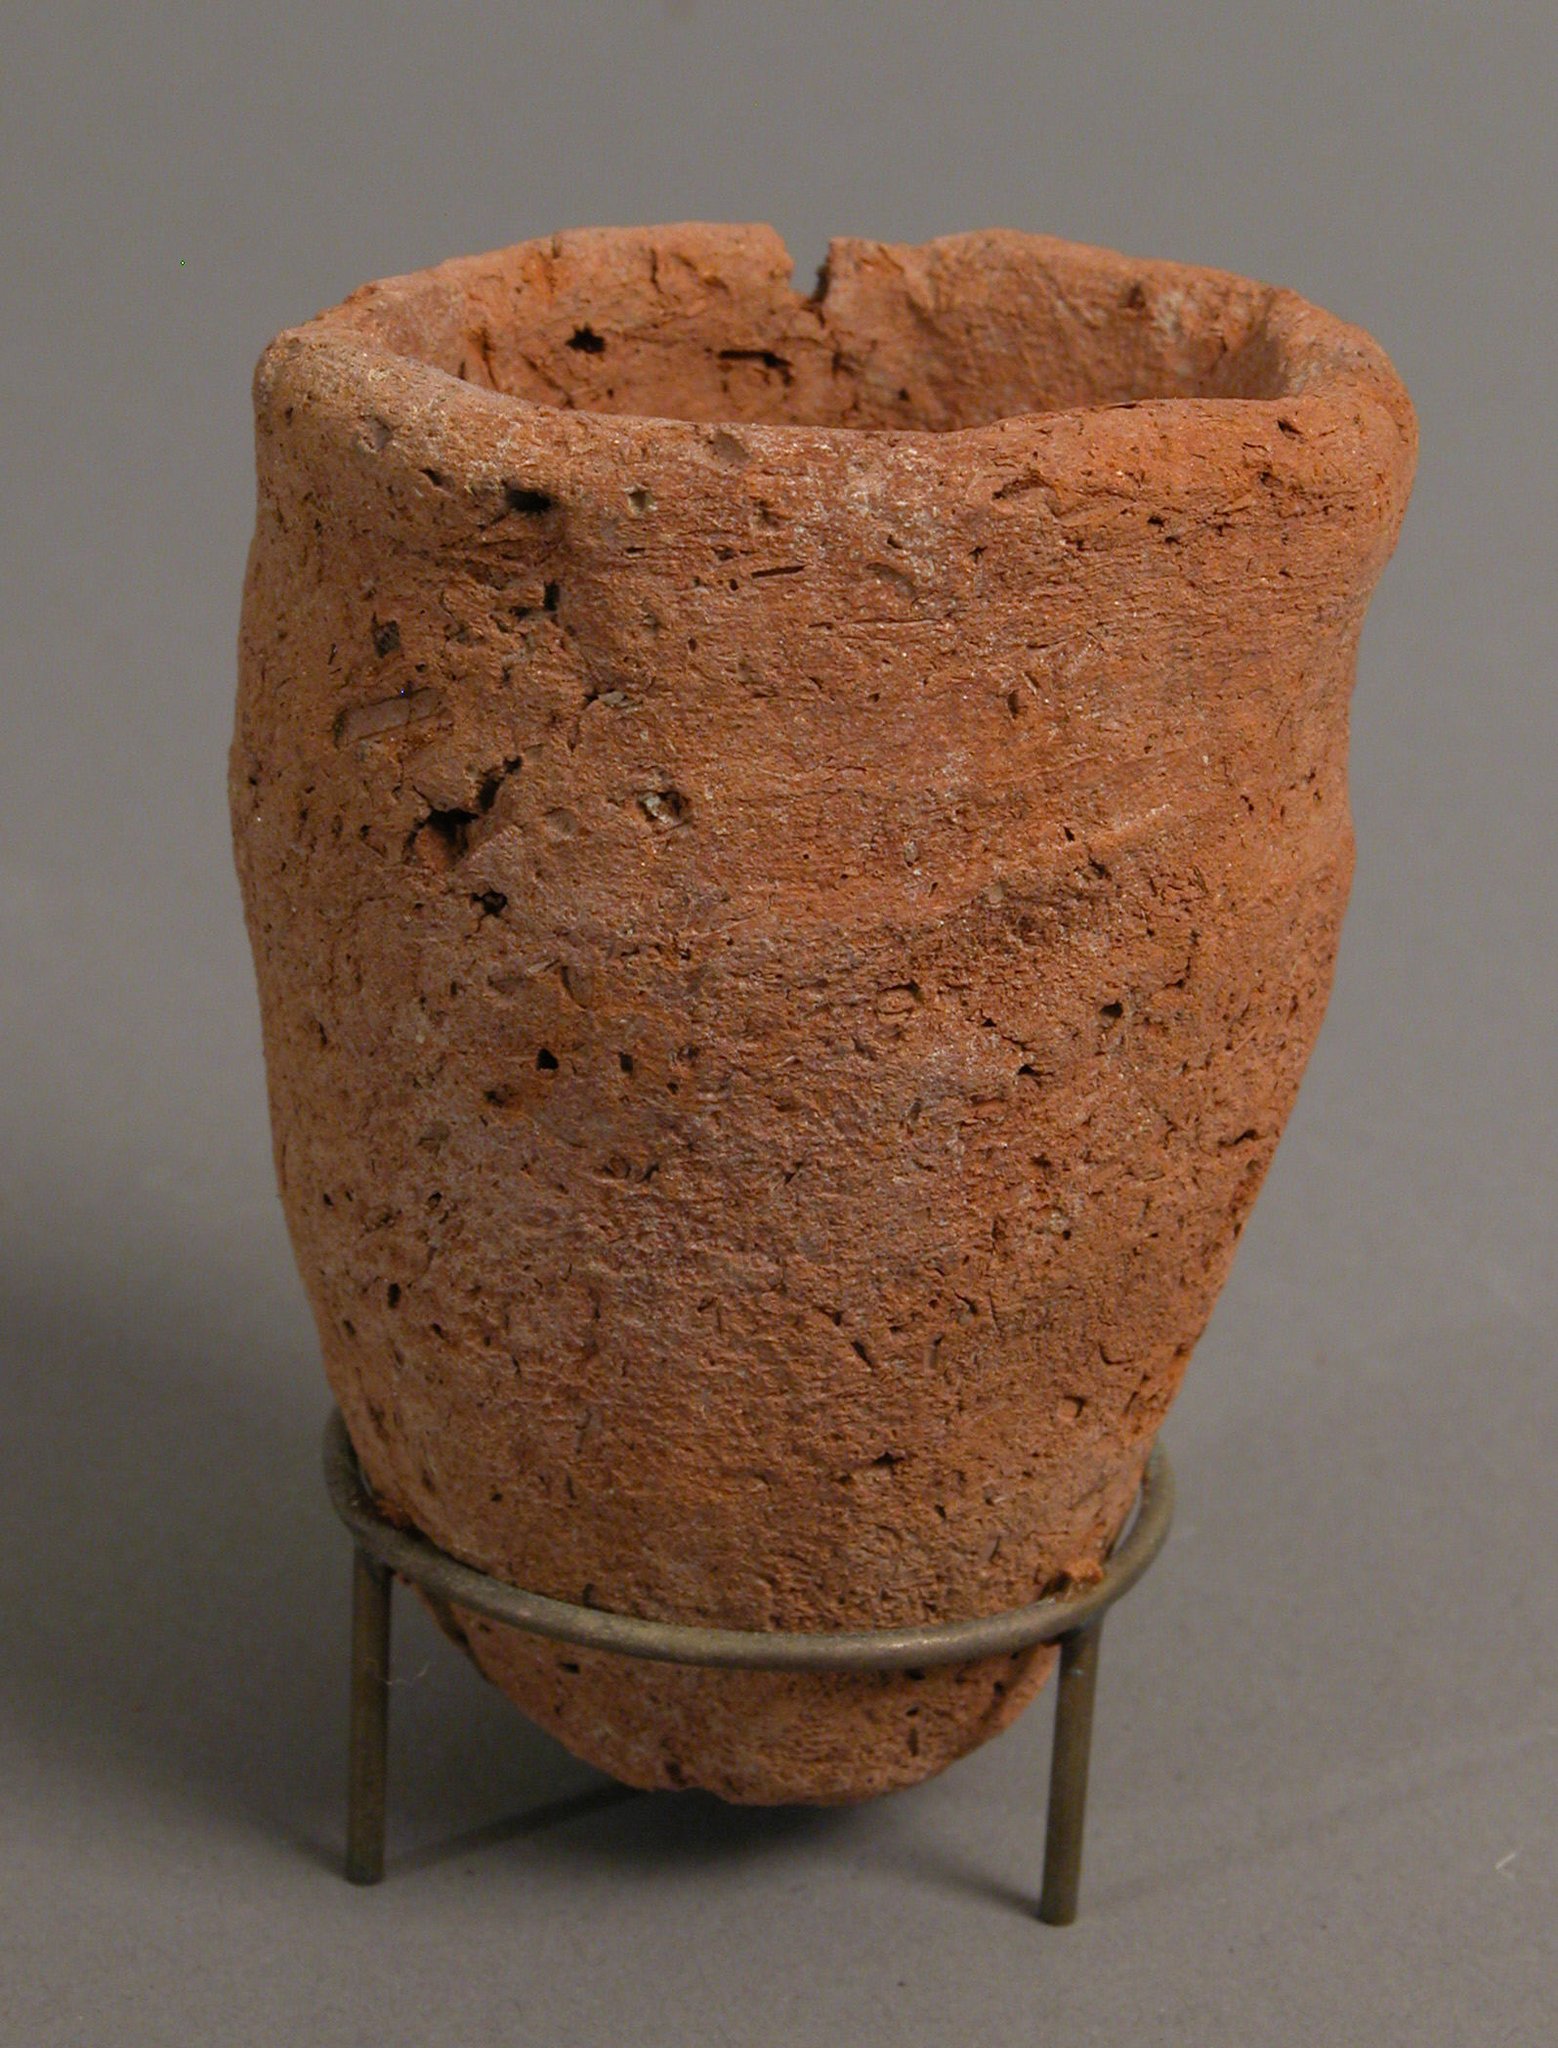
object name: pot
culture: coptic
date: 301-700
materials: earthenware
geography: egypt